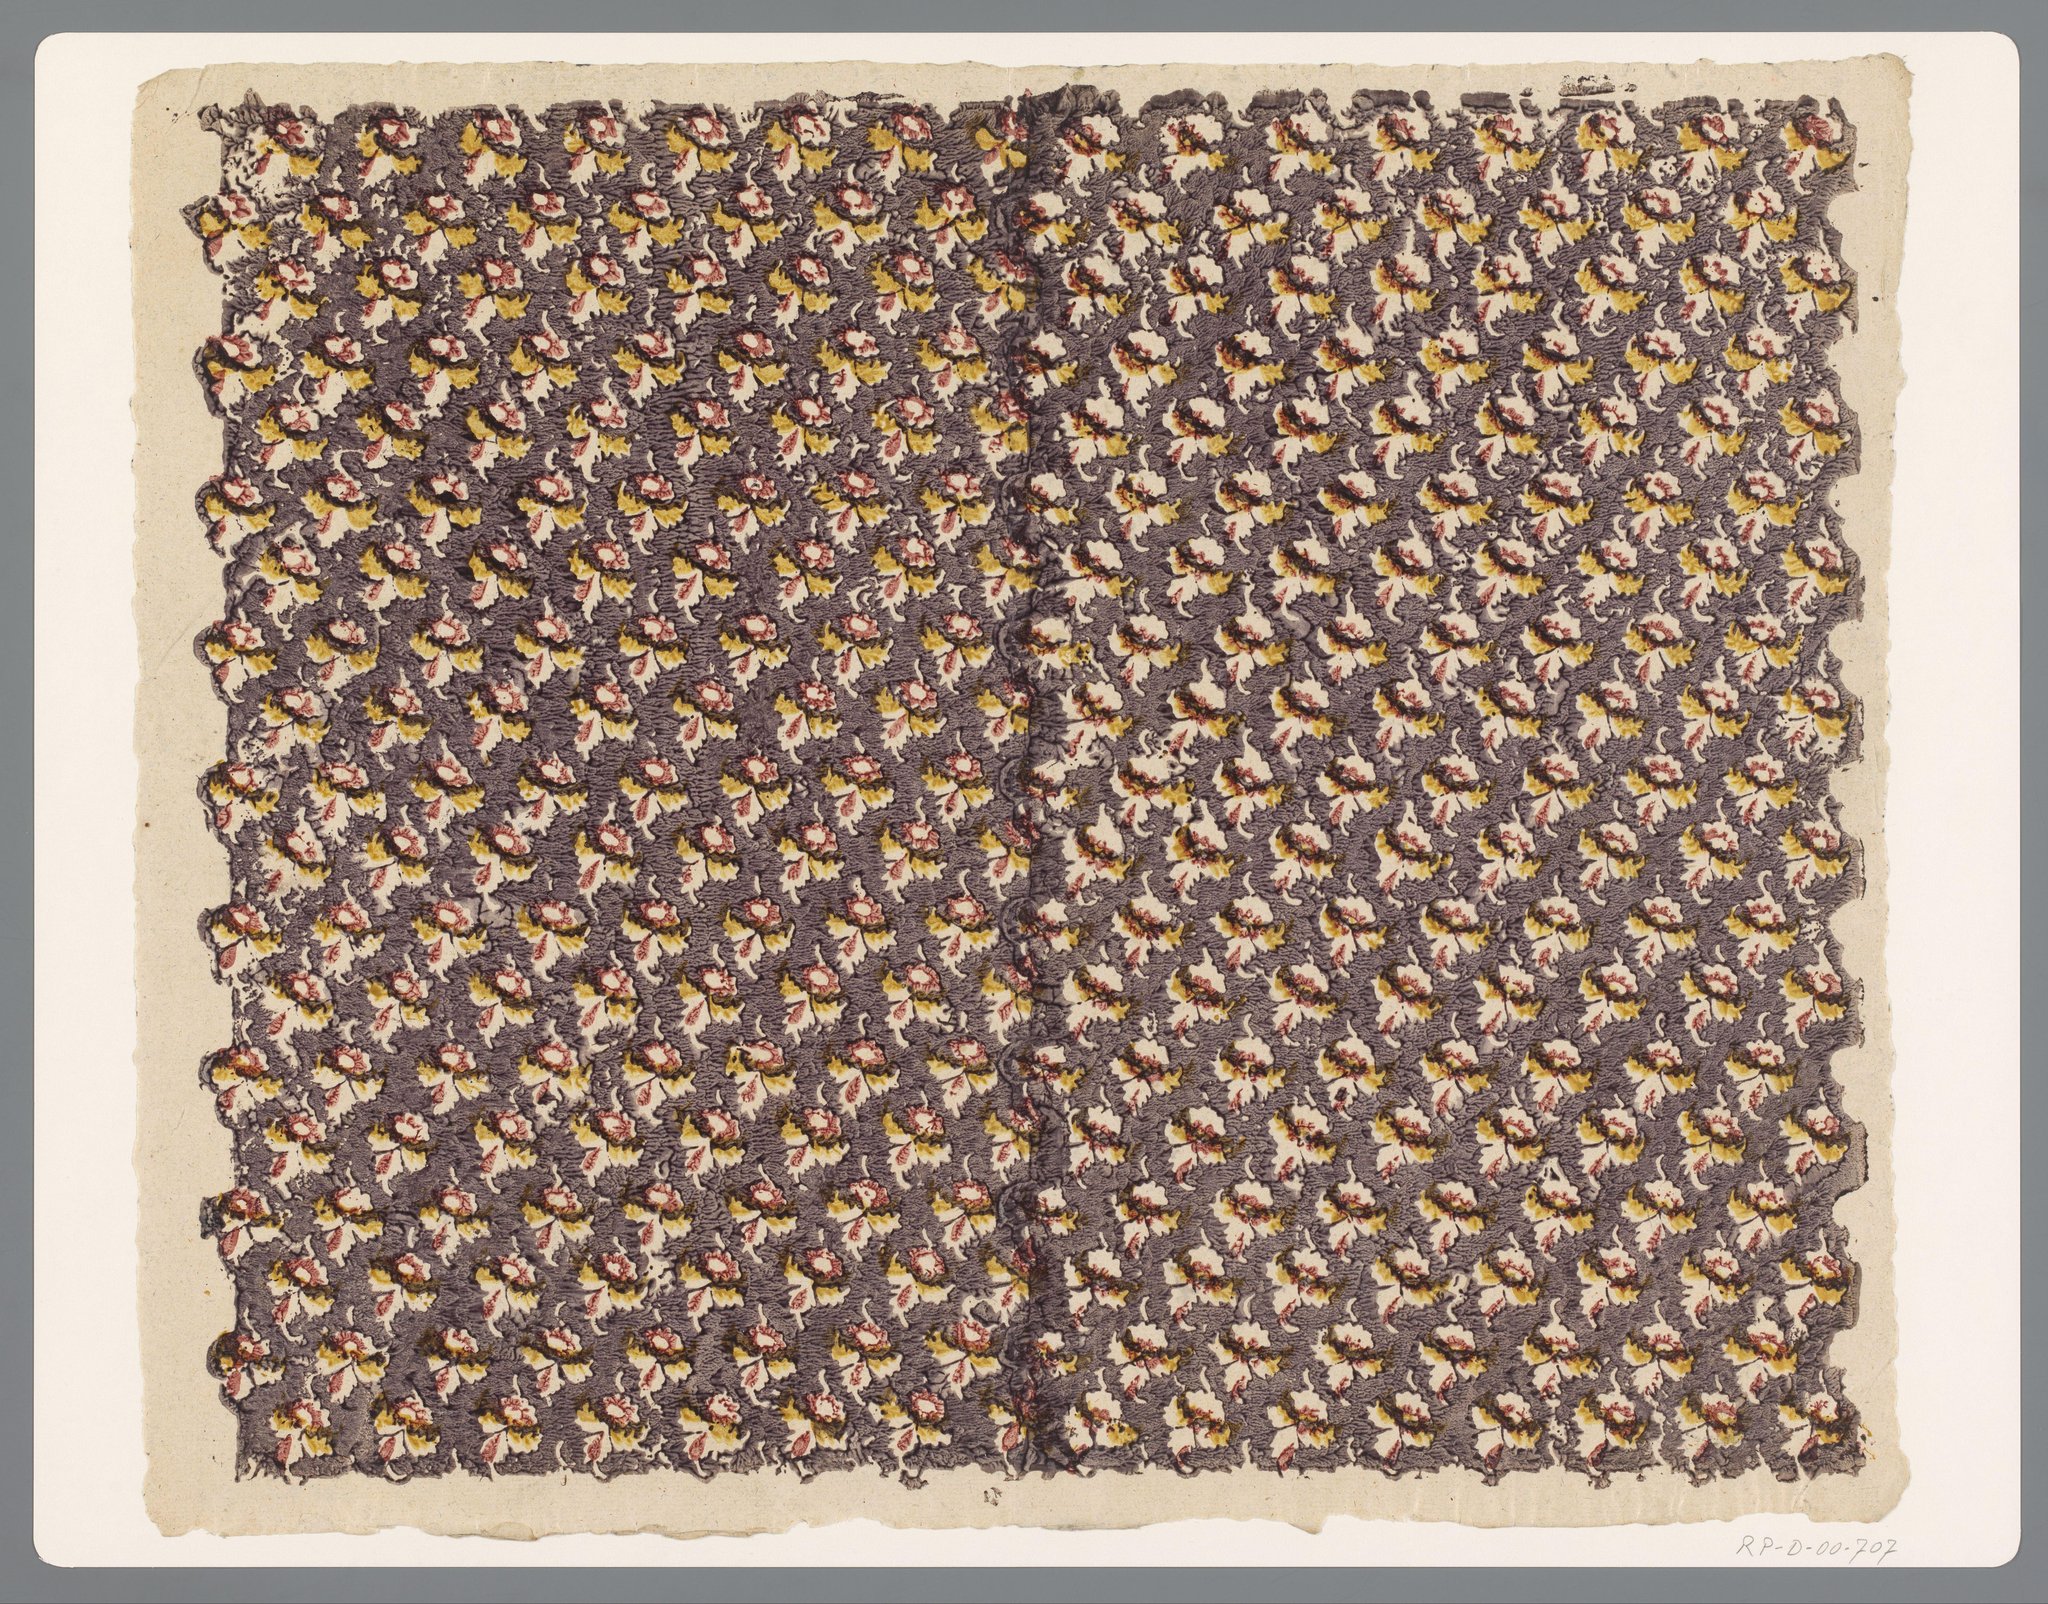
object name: printed paper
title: Blad met strooipatroon van uitgespaard bladmotief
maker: Anonymous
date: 1750-1900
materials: lacquer, paper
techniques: printing block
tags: ornament derived from animal forms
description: Blad met strooipatroon van uitgespaard bladmotief.